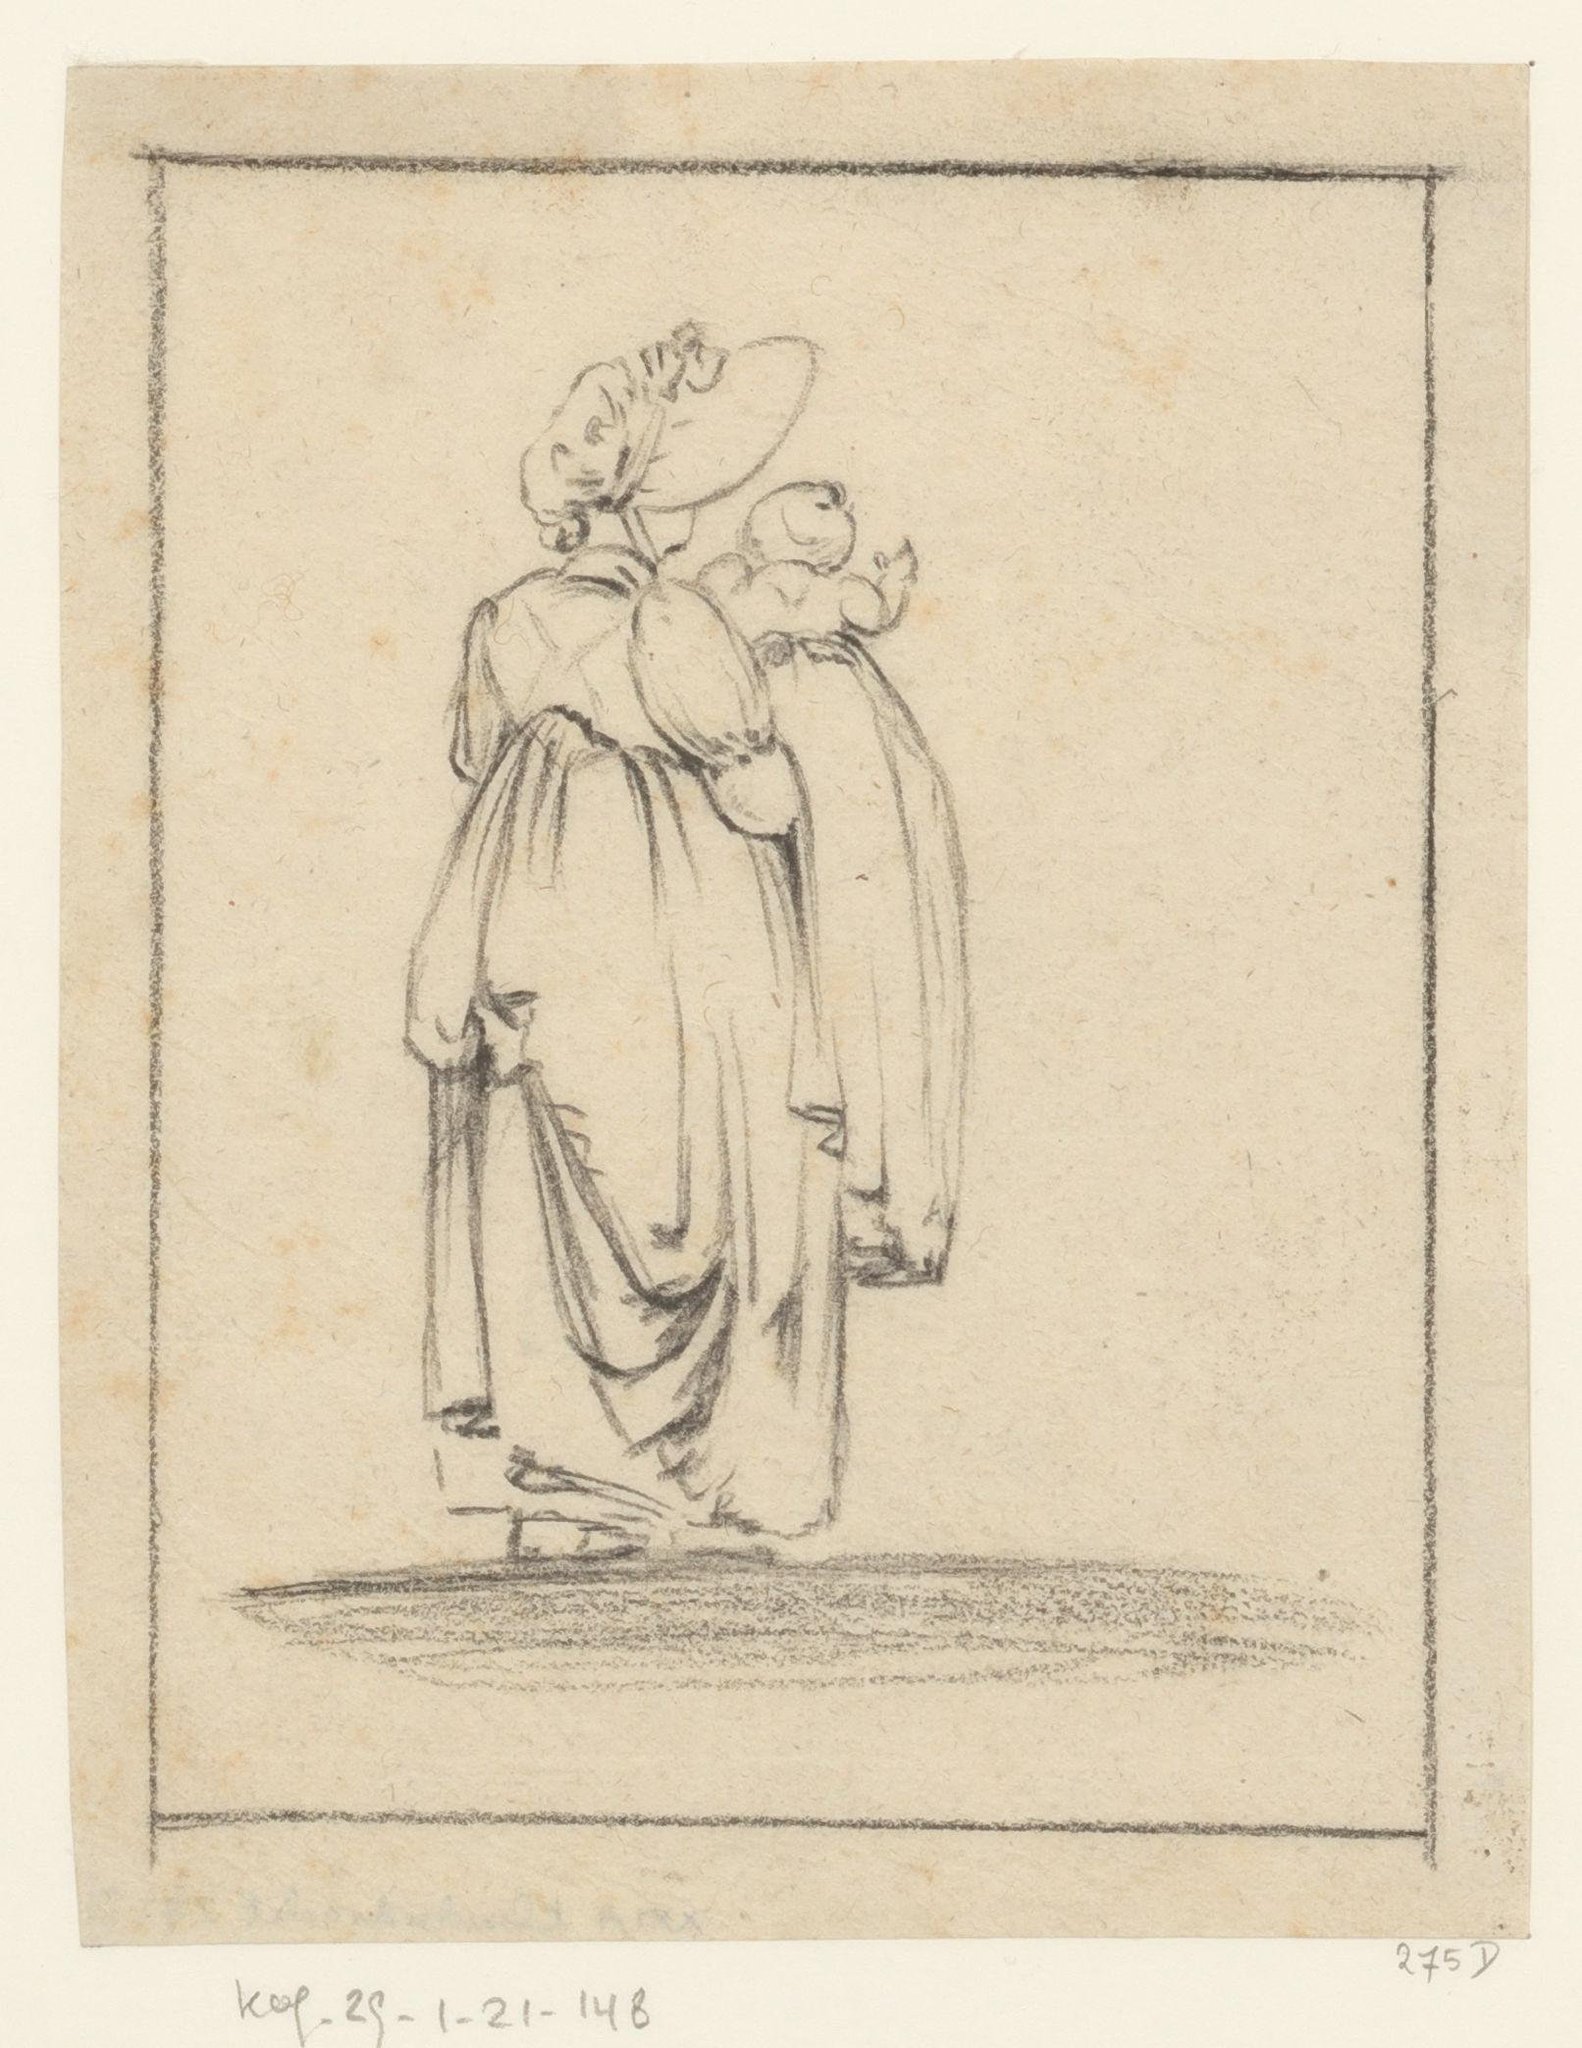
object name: drawing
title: Vrouw met kind op haar arm op de rug gezien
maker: Anonymous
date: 1800-1849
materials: chalk, paper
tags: child, head-gear: cap, standing figure - aa - female human figure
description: Onderwerpsrubrieken binnen de Atlas Zeden en Gewoonten: Zeden en Gewoonten in Engeren Zin, De Kleeding, Kleederdrachten (tijdvakken), De 18de eeuw (de revolutietijd). Mannen en vrouwen.